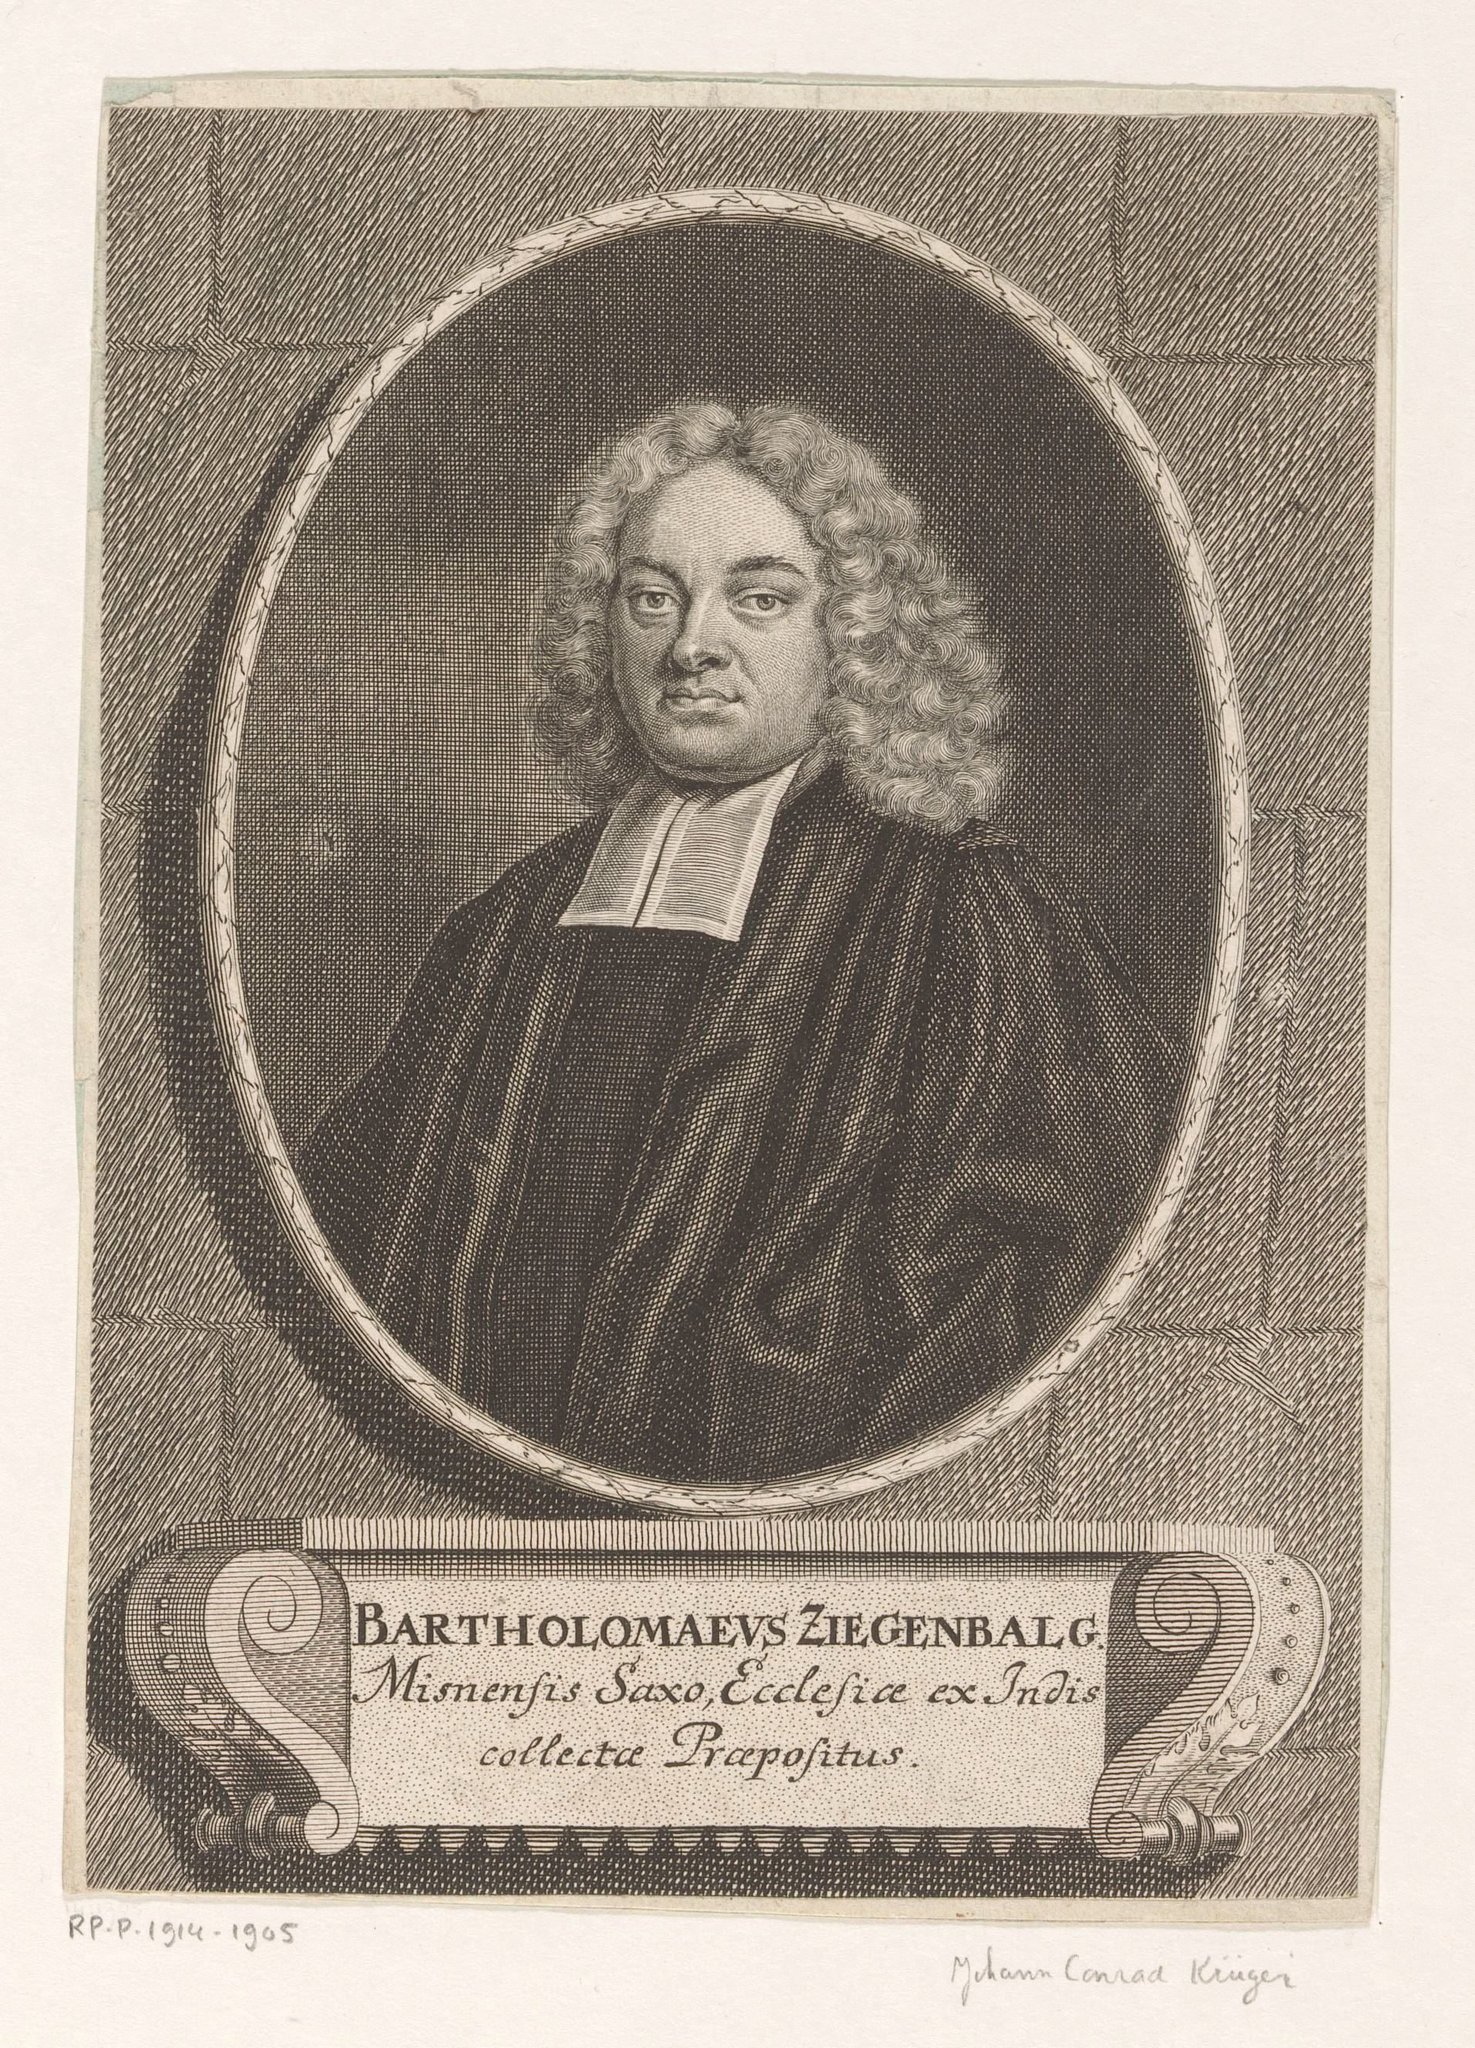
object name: print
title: Portret van Bartholomäus Ziegenbalg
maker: johann conrad krüger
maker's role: artist, painter, print maker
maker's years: 1733-1791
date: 1743-1791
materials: paper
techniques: engraving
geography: berlin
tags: historical persons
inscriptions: collector's mark: Lugt 2228